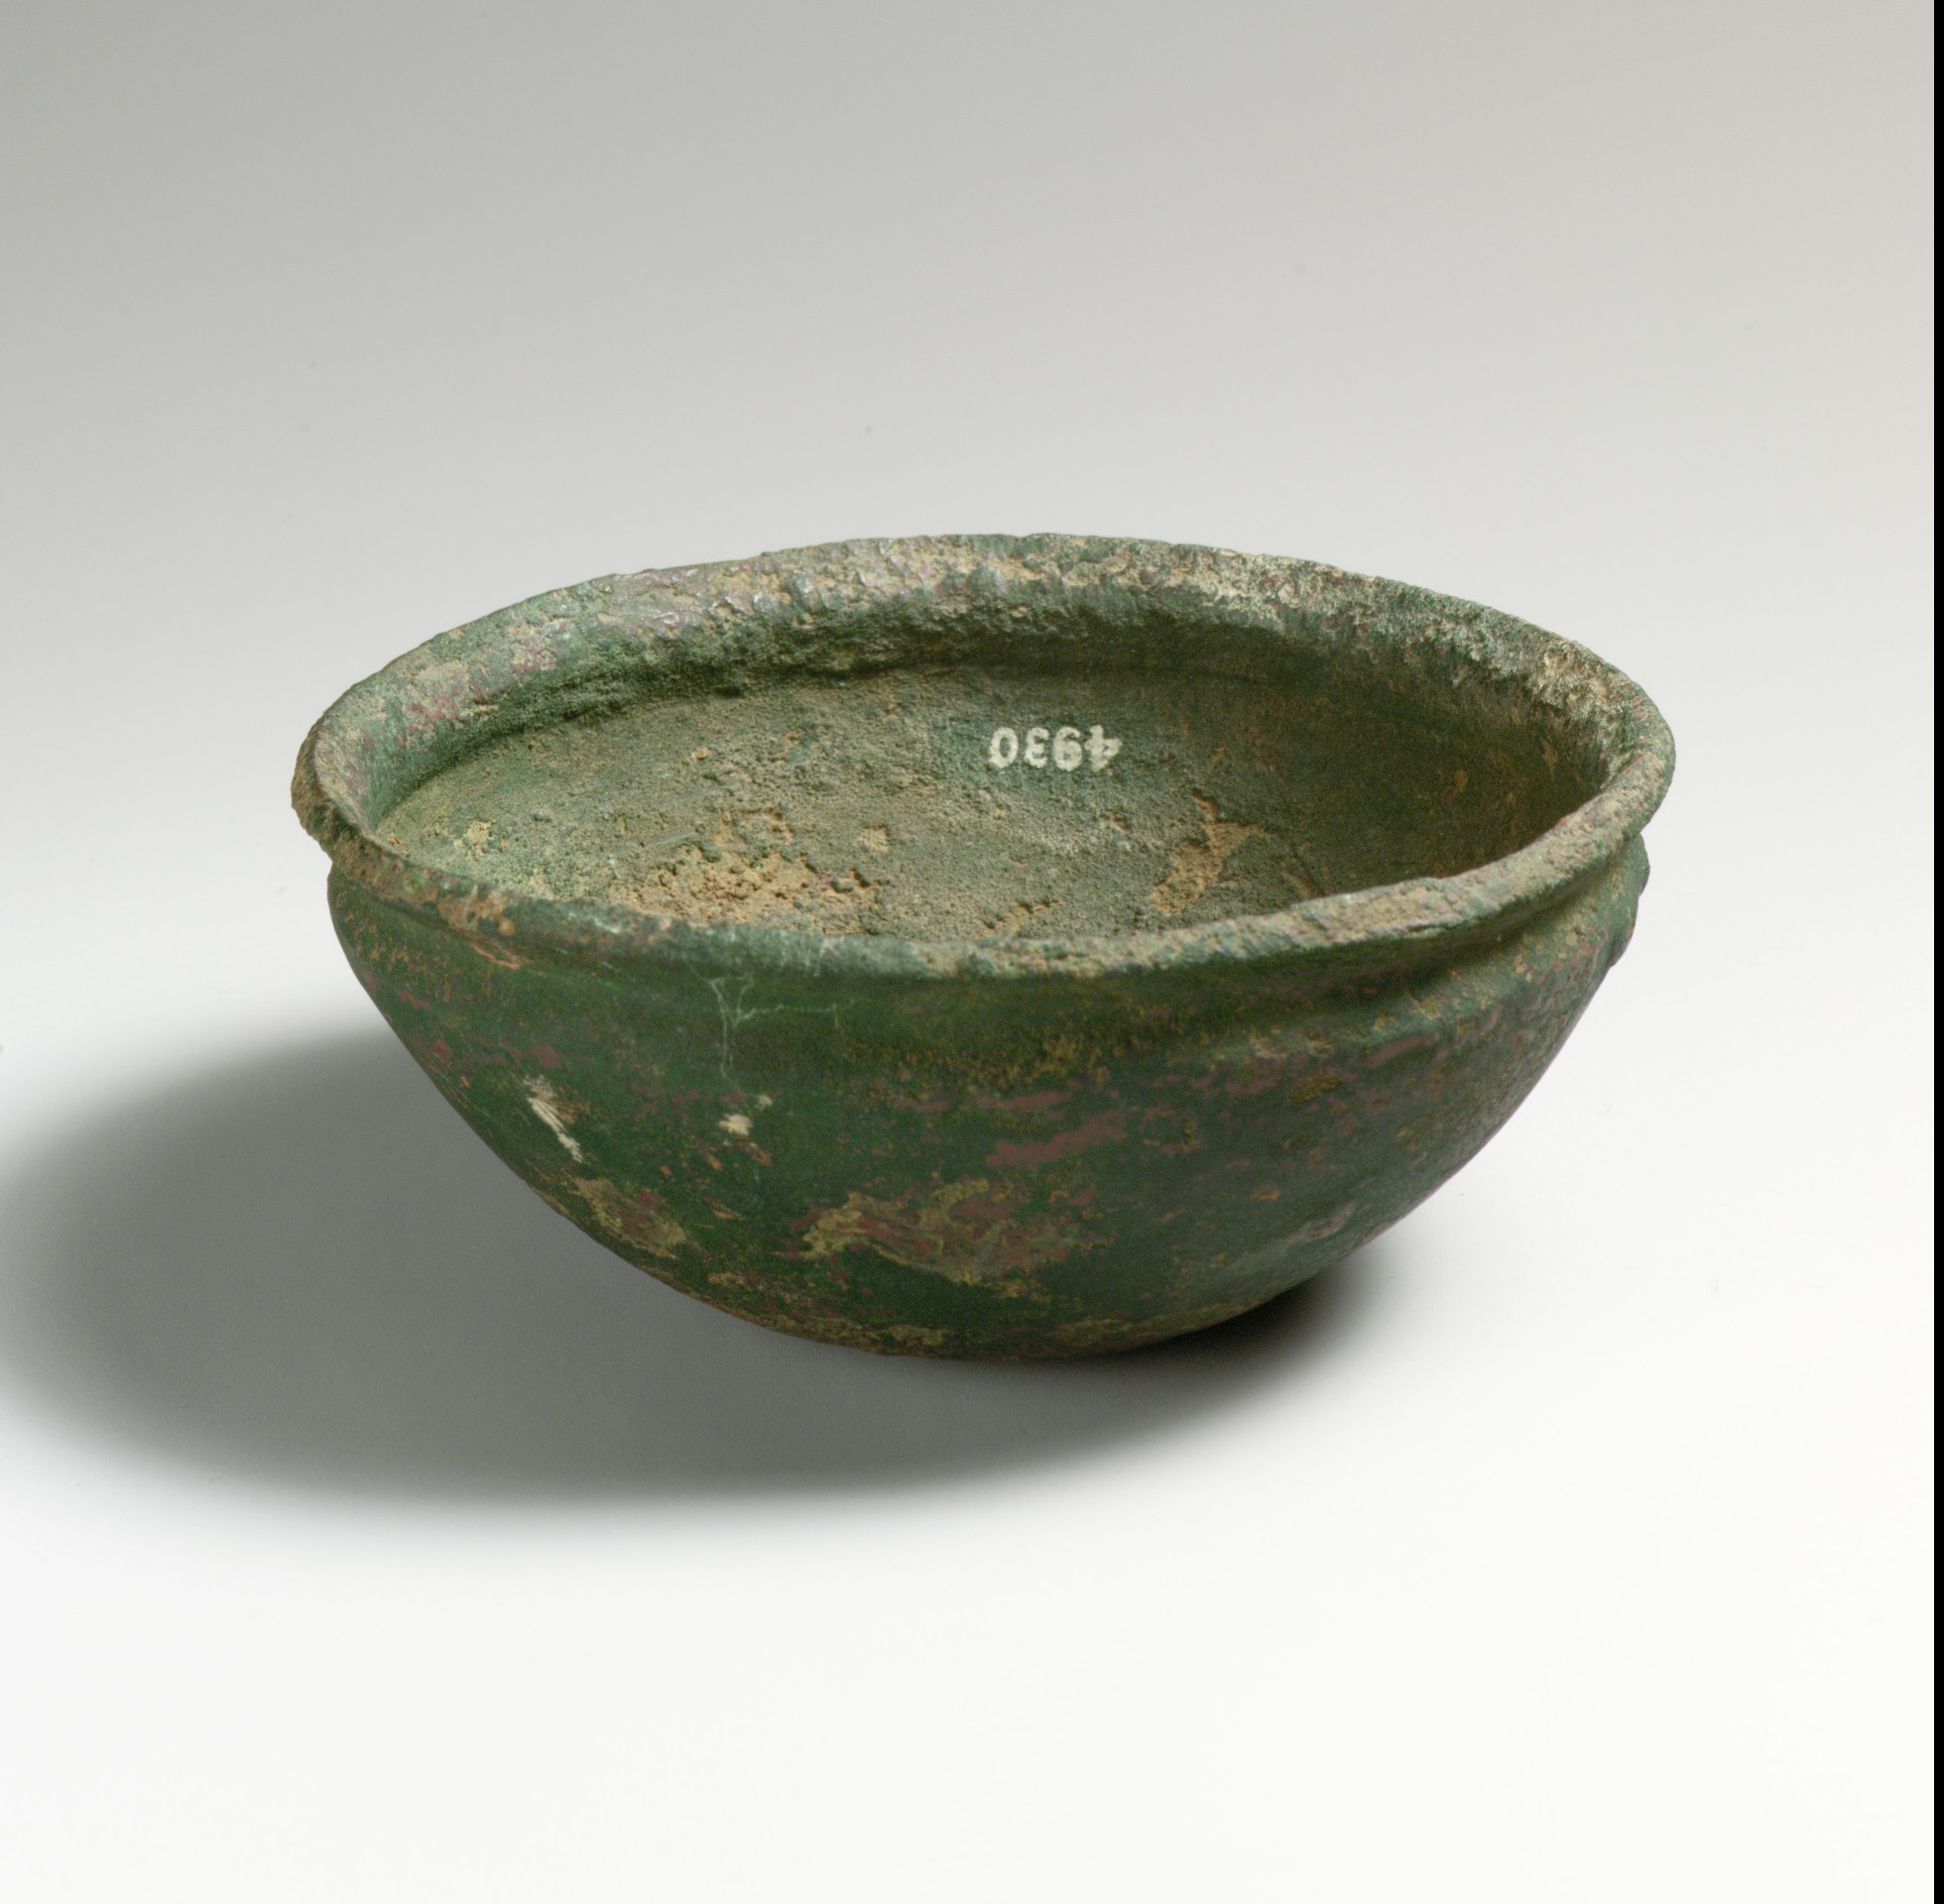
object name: phiale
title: Bronze phiale (libation bowl)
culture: cypriot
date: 600 BCE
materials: bronze